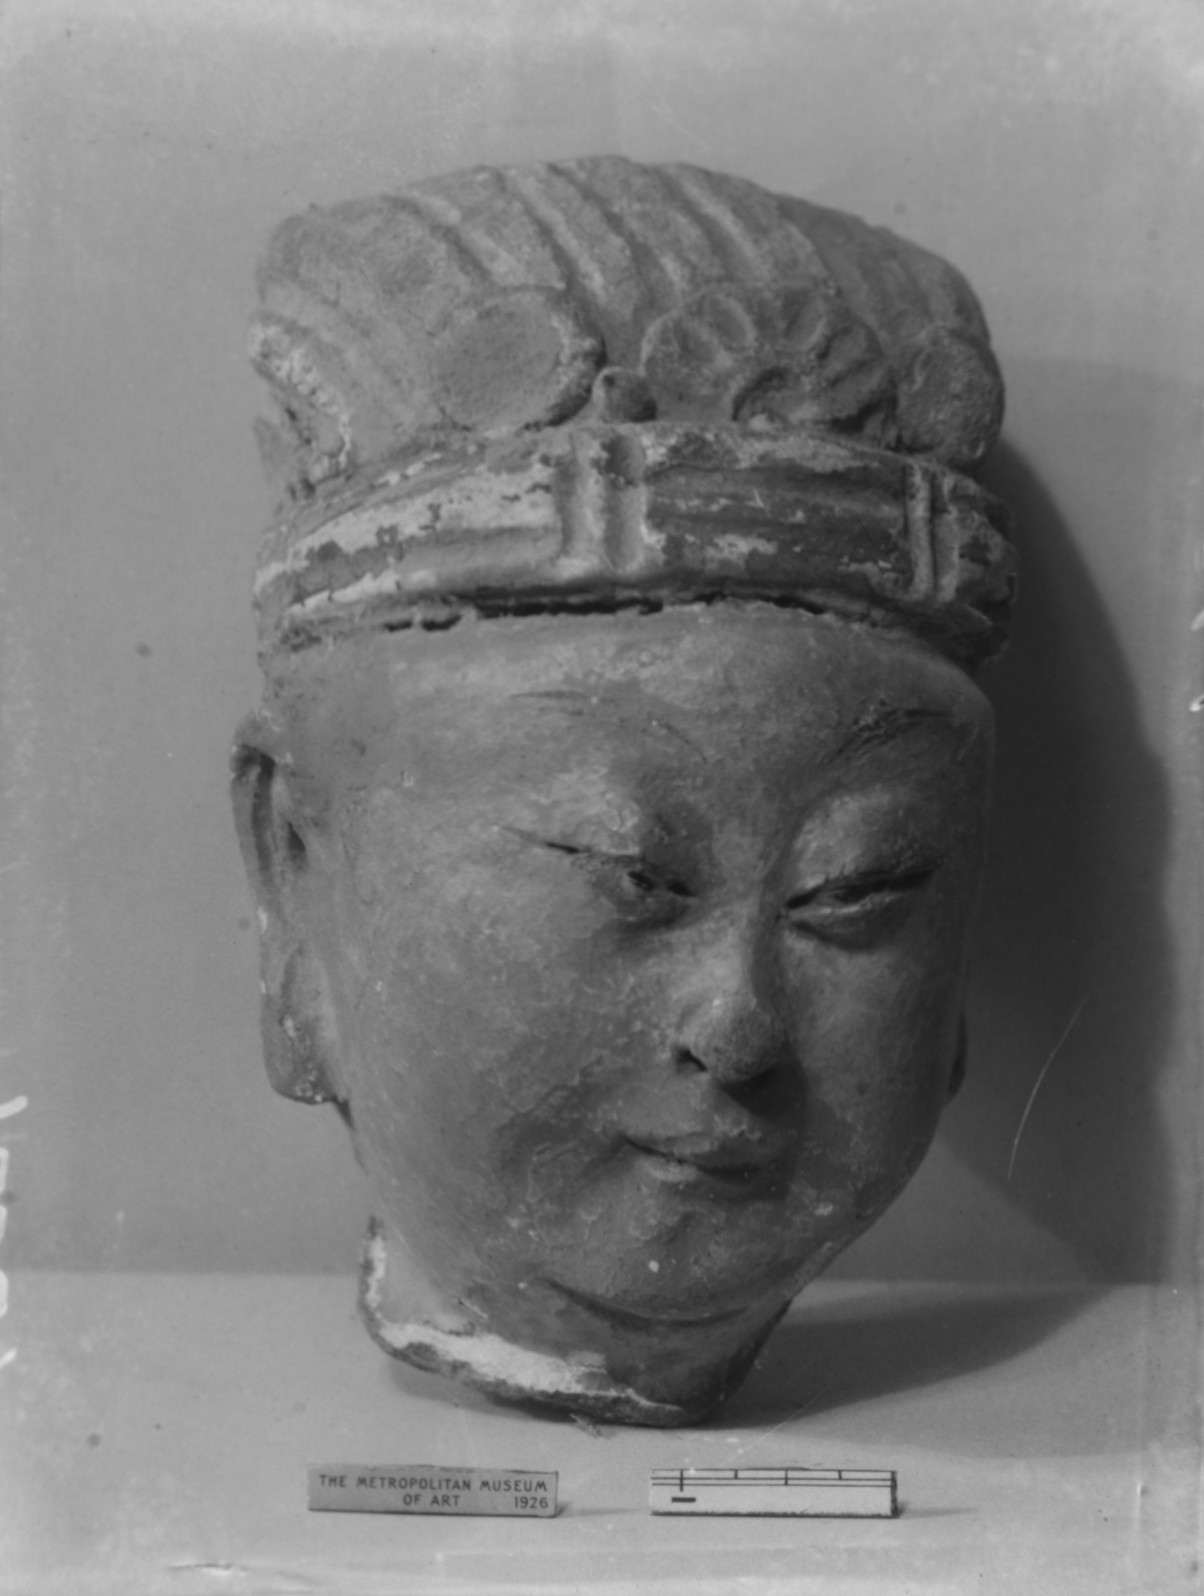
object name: head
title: Youthful Bodhisattva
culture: chinese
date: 220-589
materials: pottery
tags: heads,buddhism,bodhisattvas